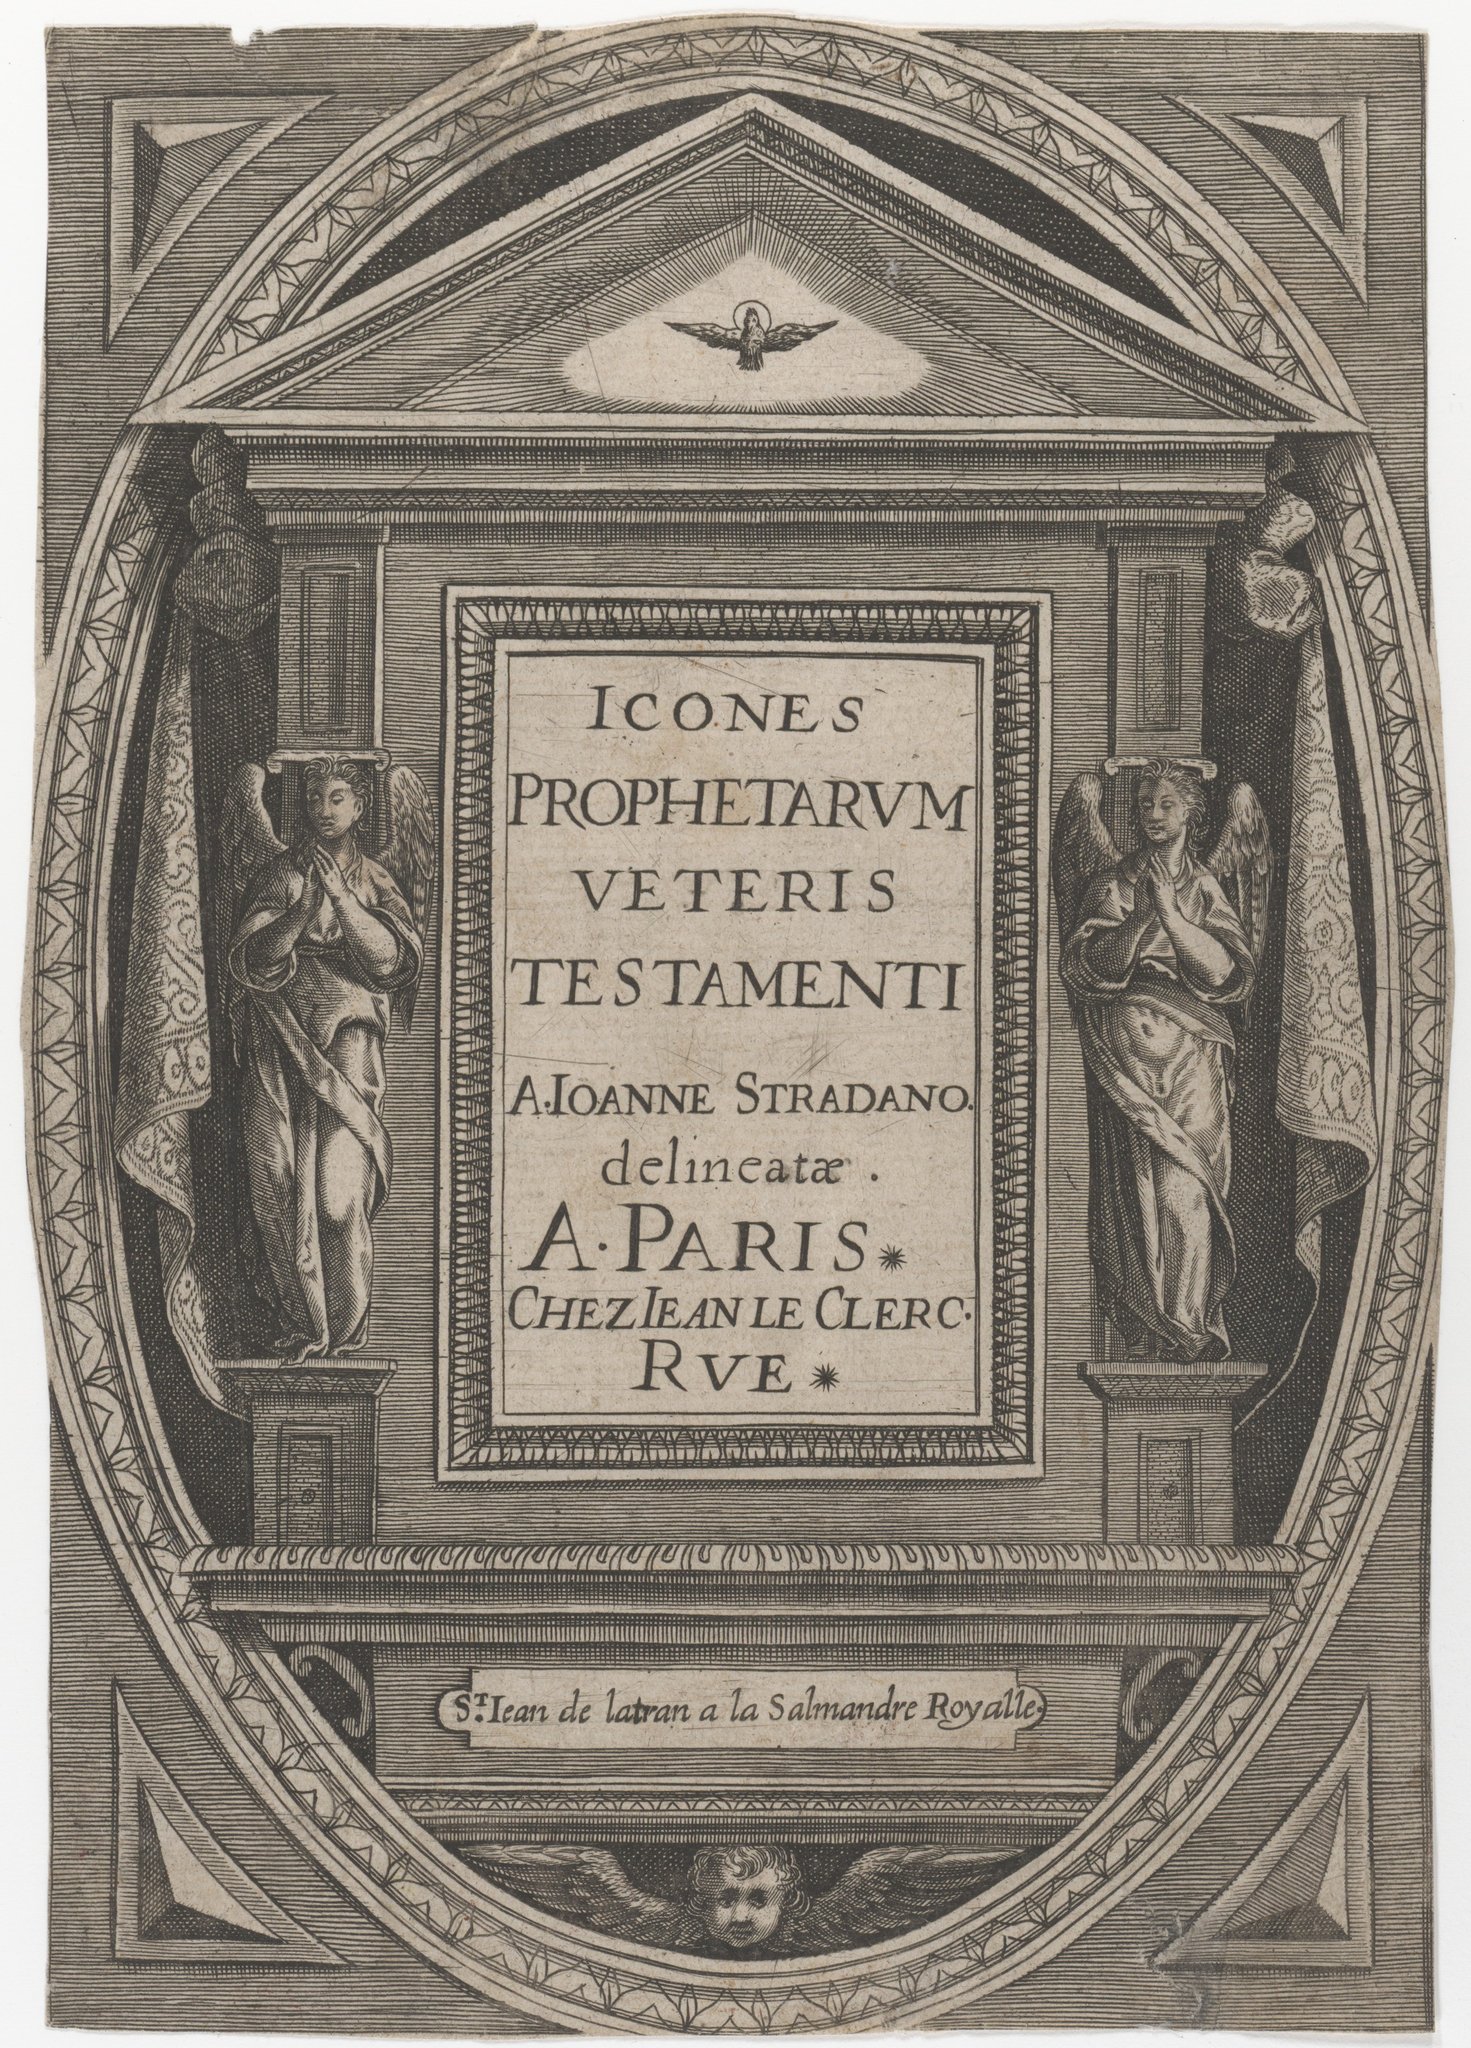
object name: print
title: Icones Prophetarum Veteris Testamenti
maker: jan van der straet, called stradanus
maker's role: artist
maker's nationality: netherlandish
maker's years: 1523-1605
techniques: engraving